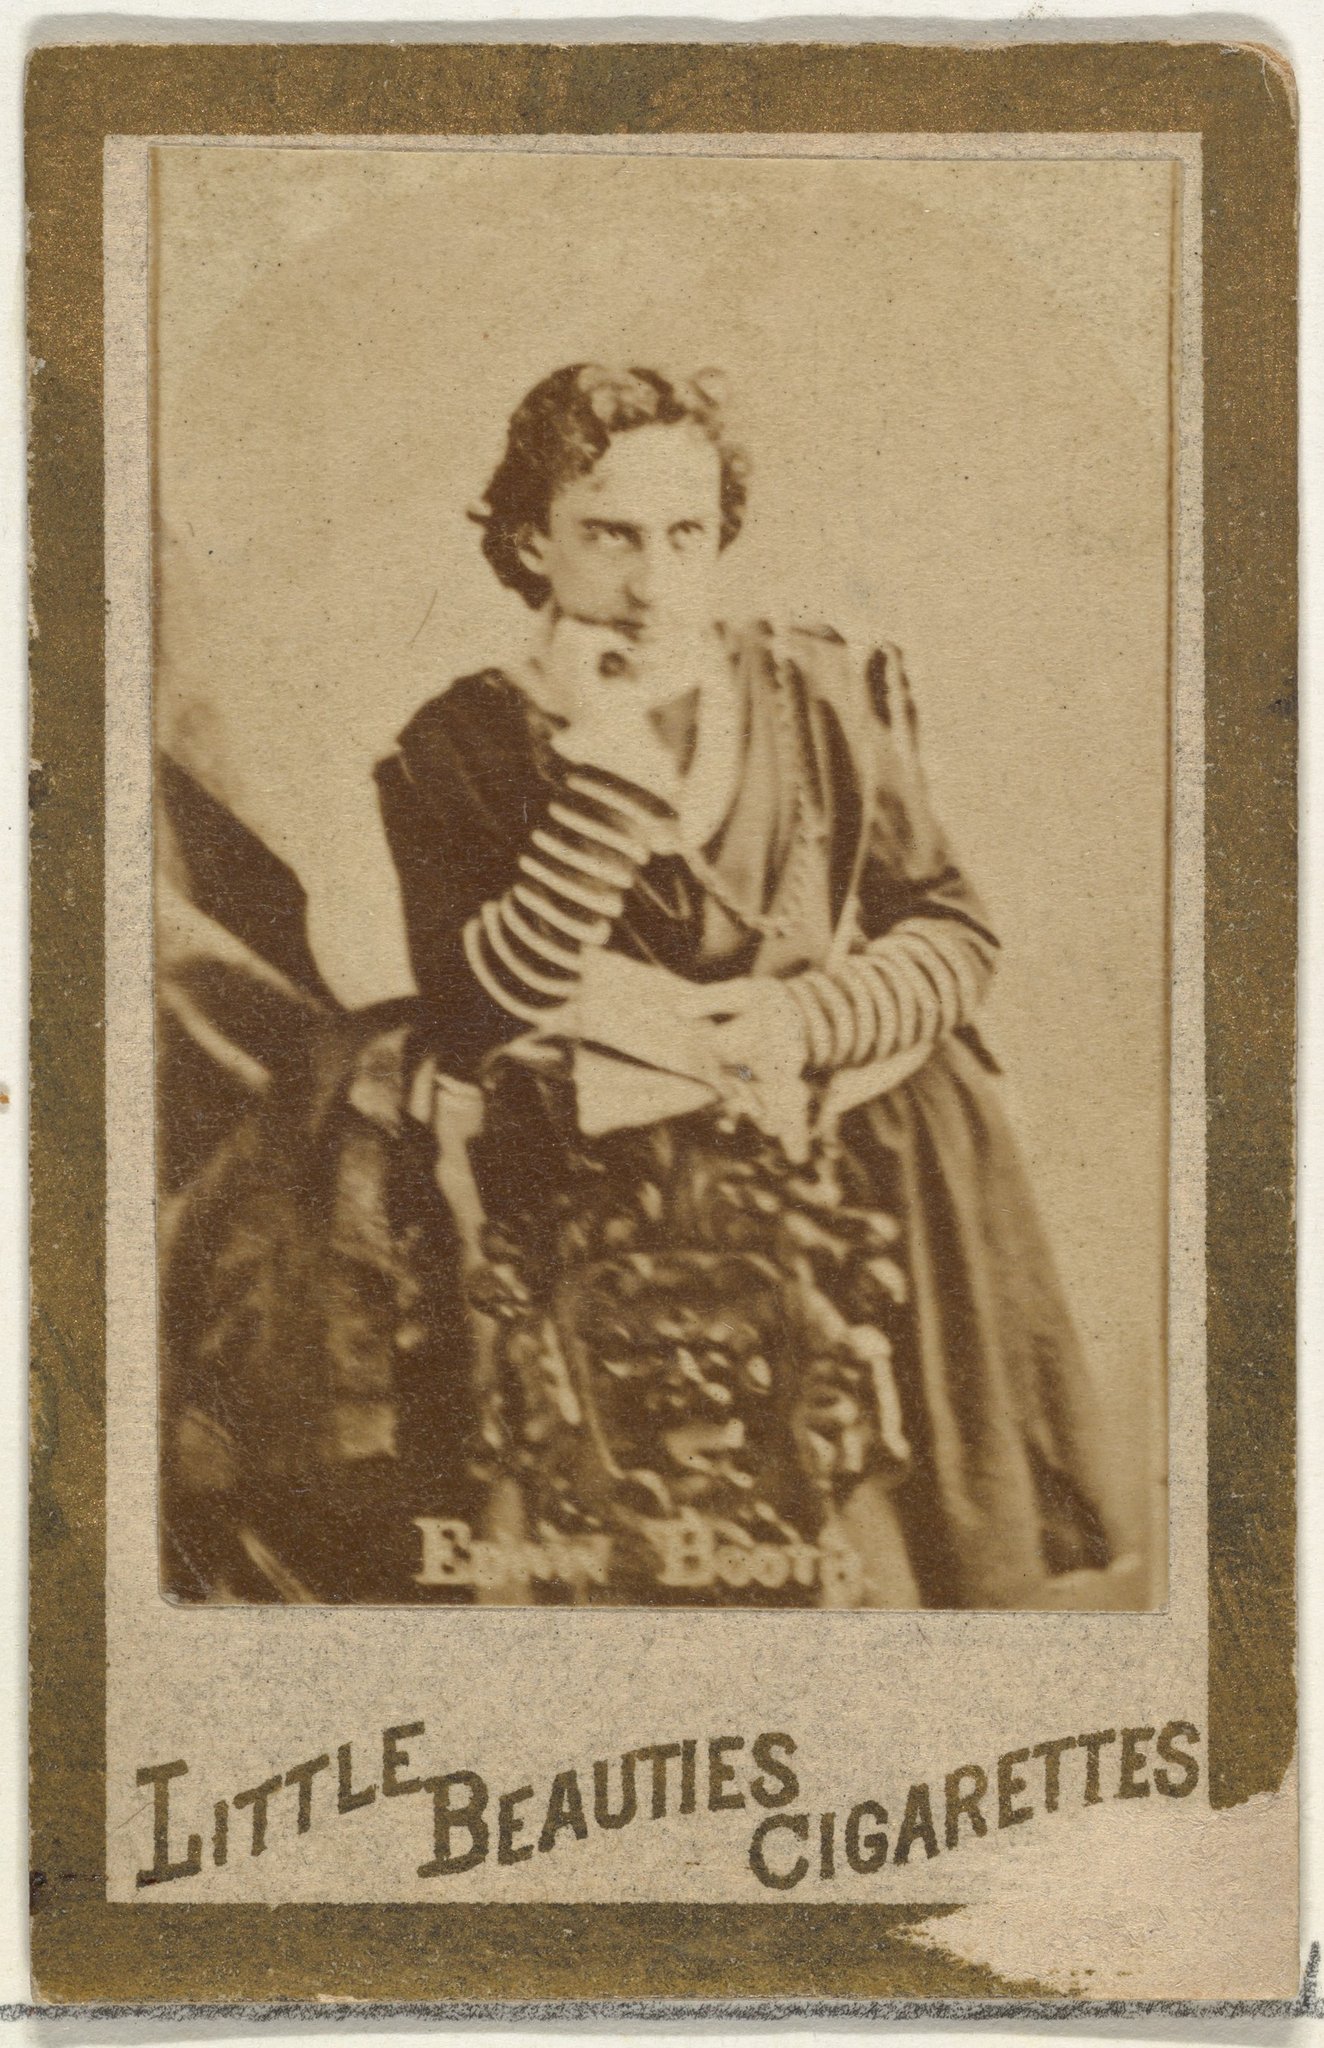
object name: photograph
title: Edwin Booth, from the Actresses and Celebrities series (N60, Type 1) promoting Little Beauties Cigarettes for Allen & Ginter brand tobacco products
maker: allen & ginter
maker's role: publisher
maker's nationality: american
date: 1887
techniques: albumen silver print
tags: men,portraits,actors